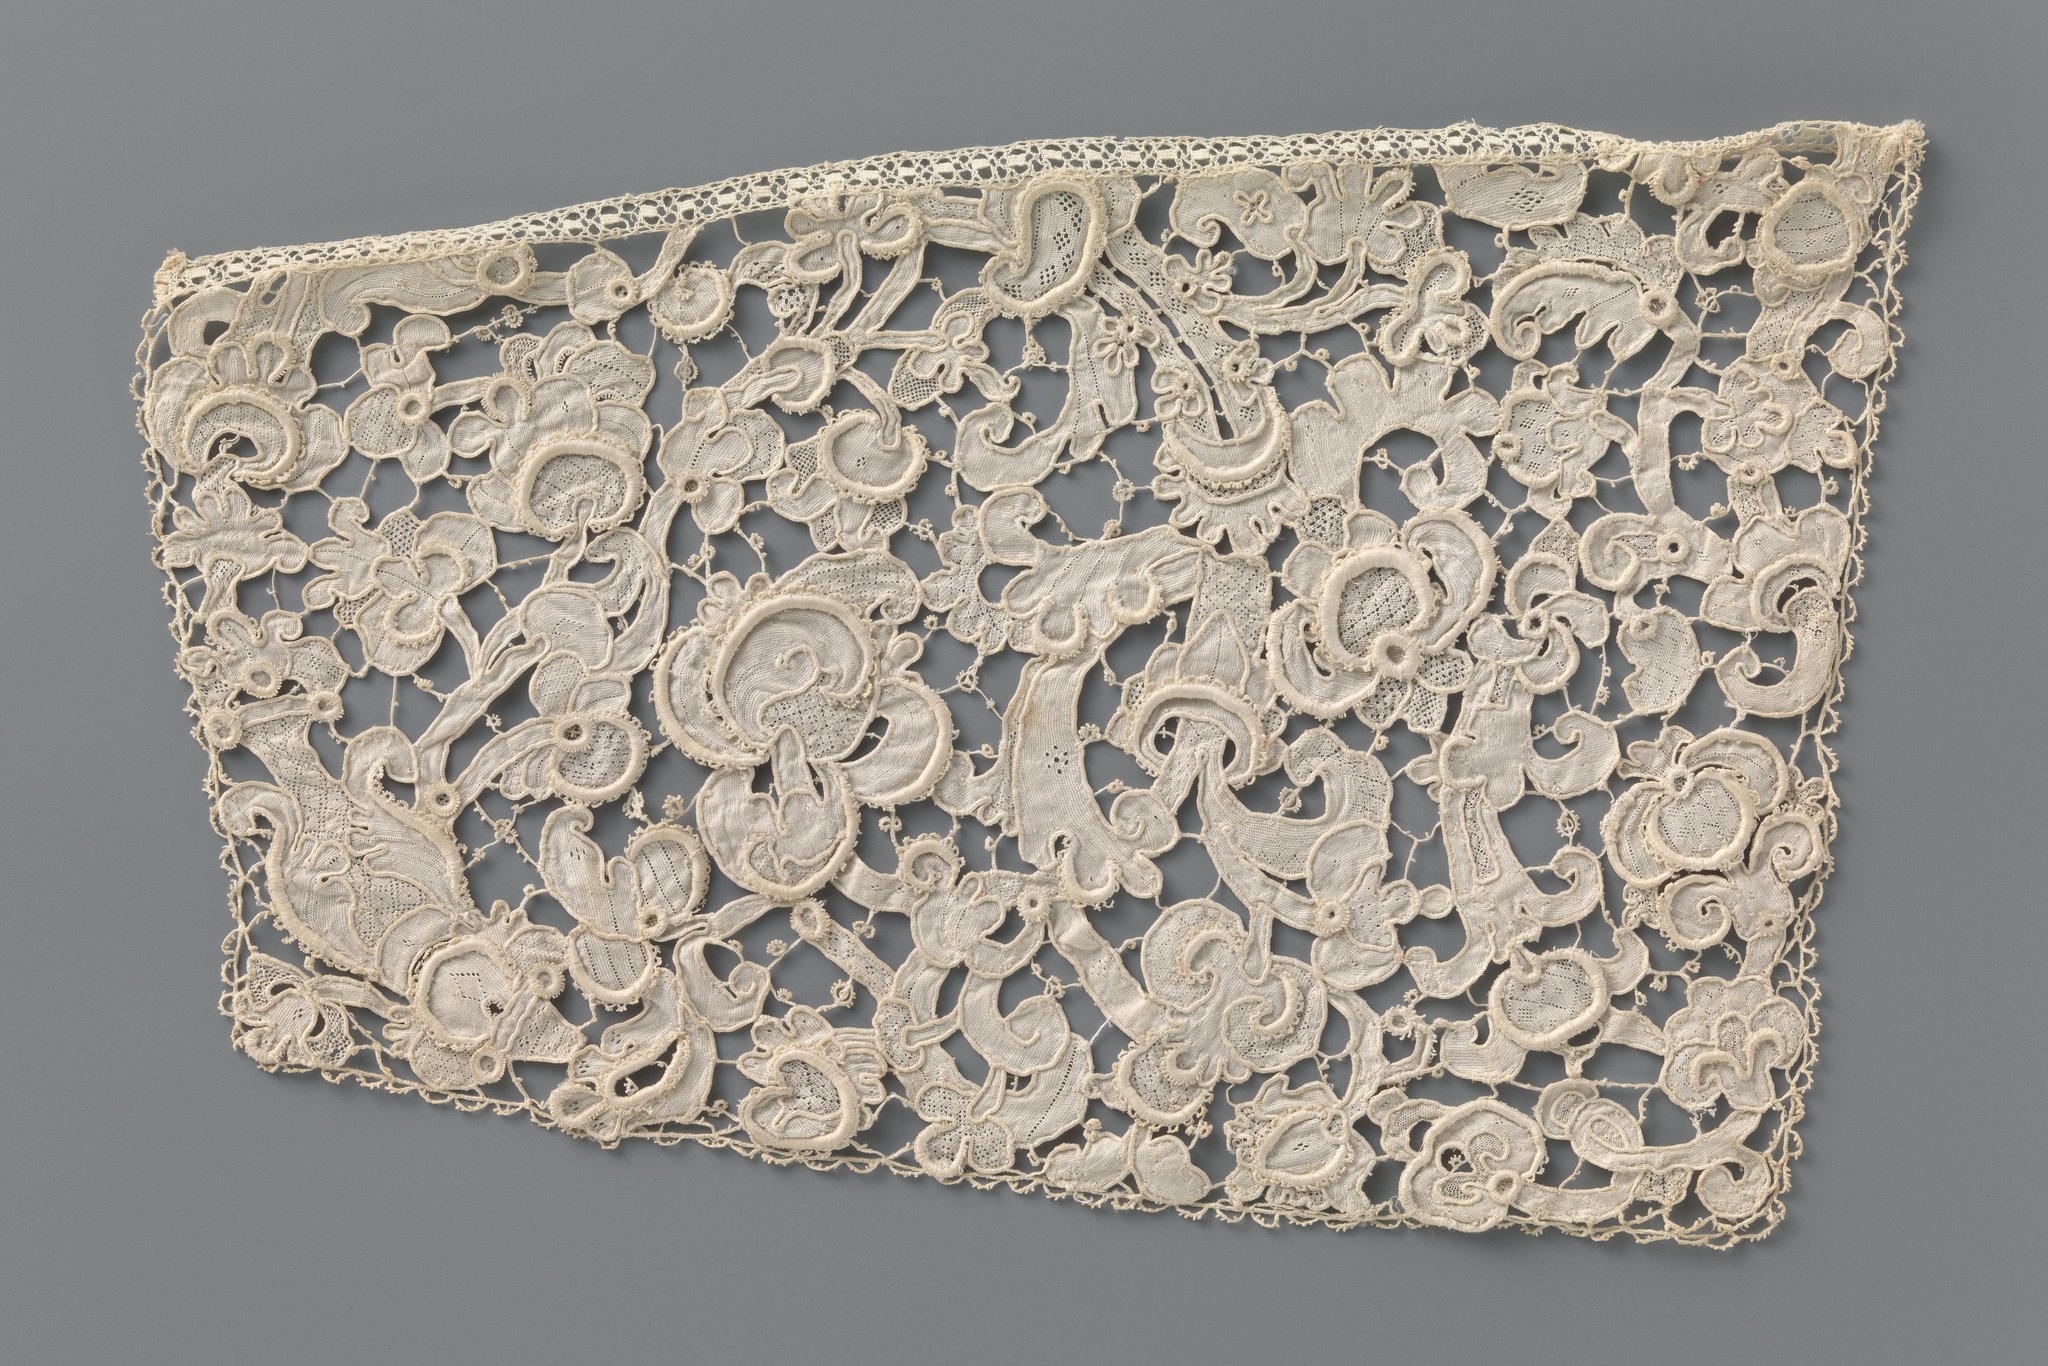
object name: vest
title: Vestje van naaldkant met getorste rank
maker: Anonymous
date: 1800-1899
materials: linen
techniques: embroidery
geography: burano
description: Vestje van naturelkleurige naaldkant: Venetiaanse reliëfkant. Op een spijlengrond staan onregelmatige ranken met middelgrote bloemen en bladvoluten. Grote driehoekjes vormen met een rechte lijst de afwerking langs een deel van de omtrek. In één der delen is een smalle strook terug te vinden van een fijner rankenspel, waarin een rank driemaal getorst is.